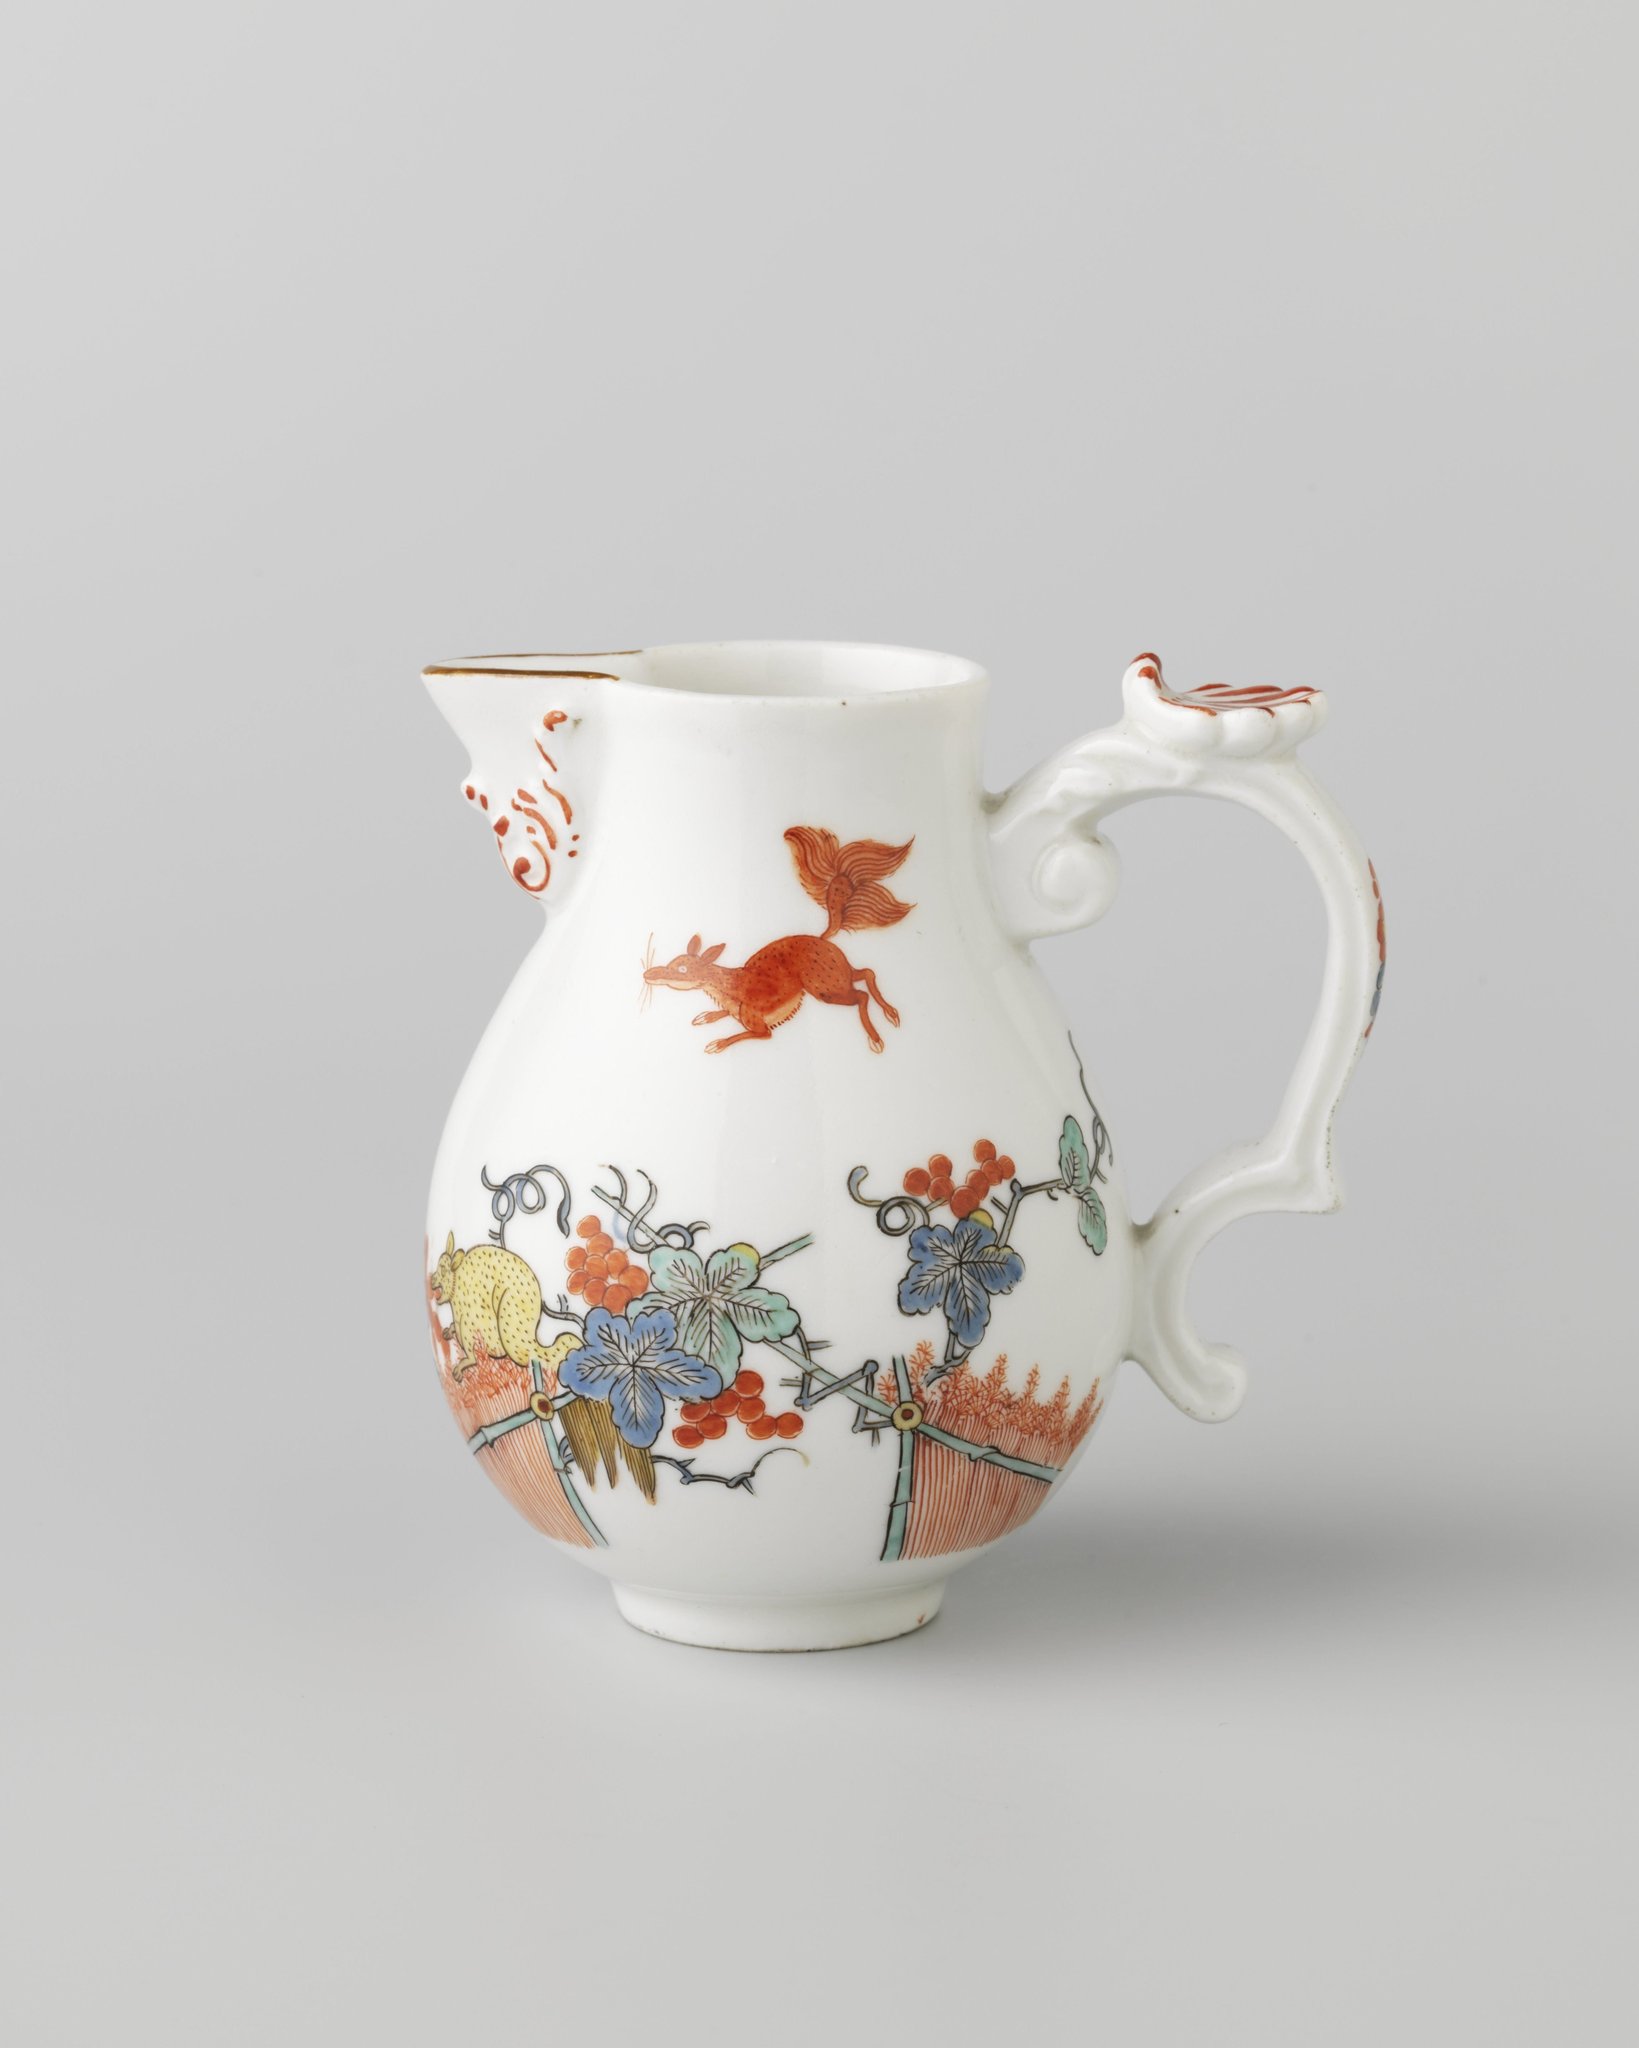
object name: milk jug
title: Melkkan, veelkleurig beschilderd met een Kakiemon-decor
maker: johann daniel rehschuh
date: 1735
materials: porcelain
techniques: painted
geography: meissen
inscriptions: factory mark, mold mark: ‘X (Rückert 1996, afb. 6, nr. 33)’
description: Milk jug (cover missing). Meissen, c. 1730 - 1740.